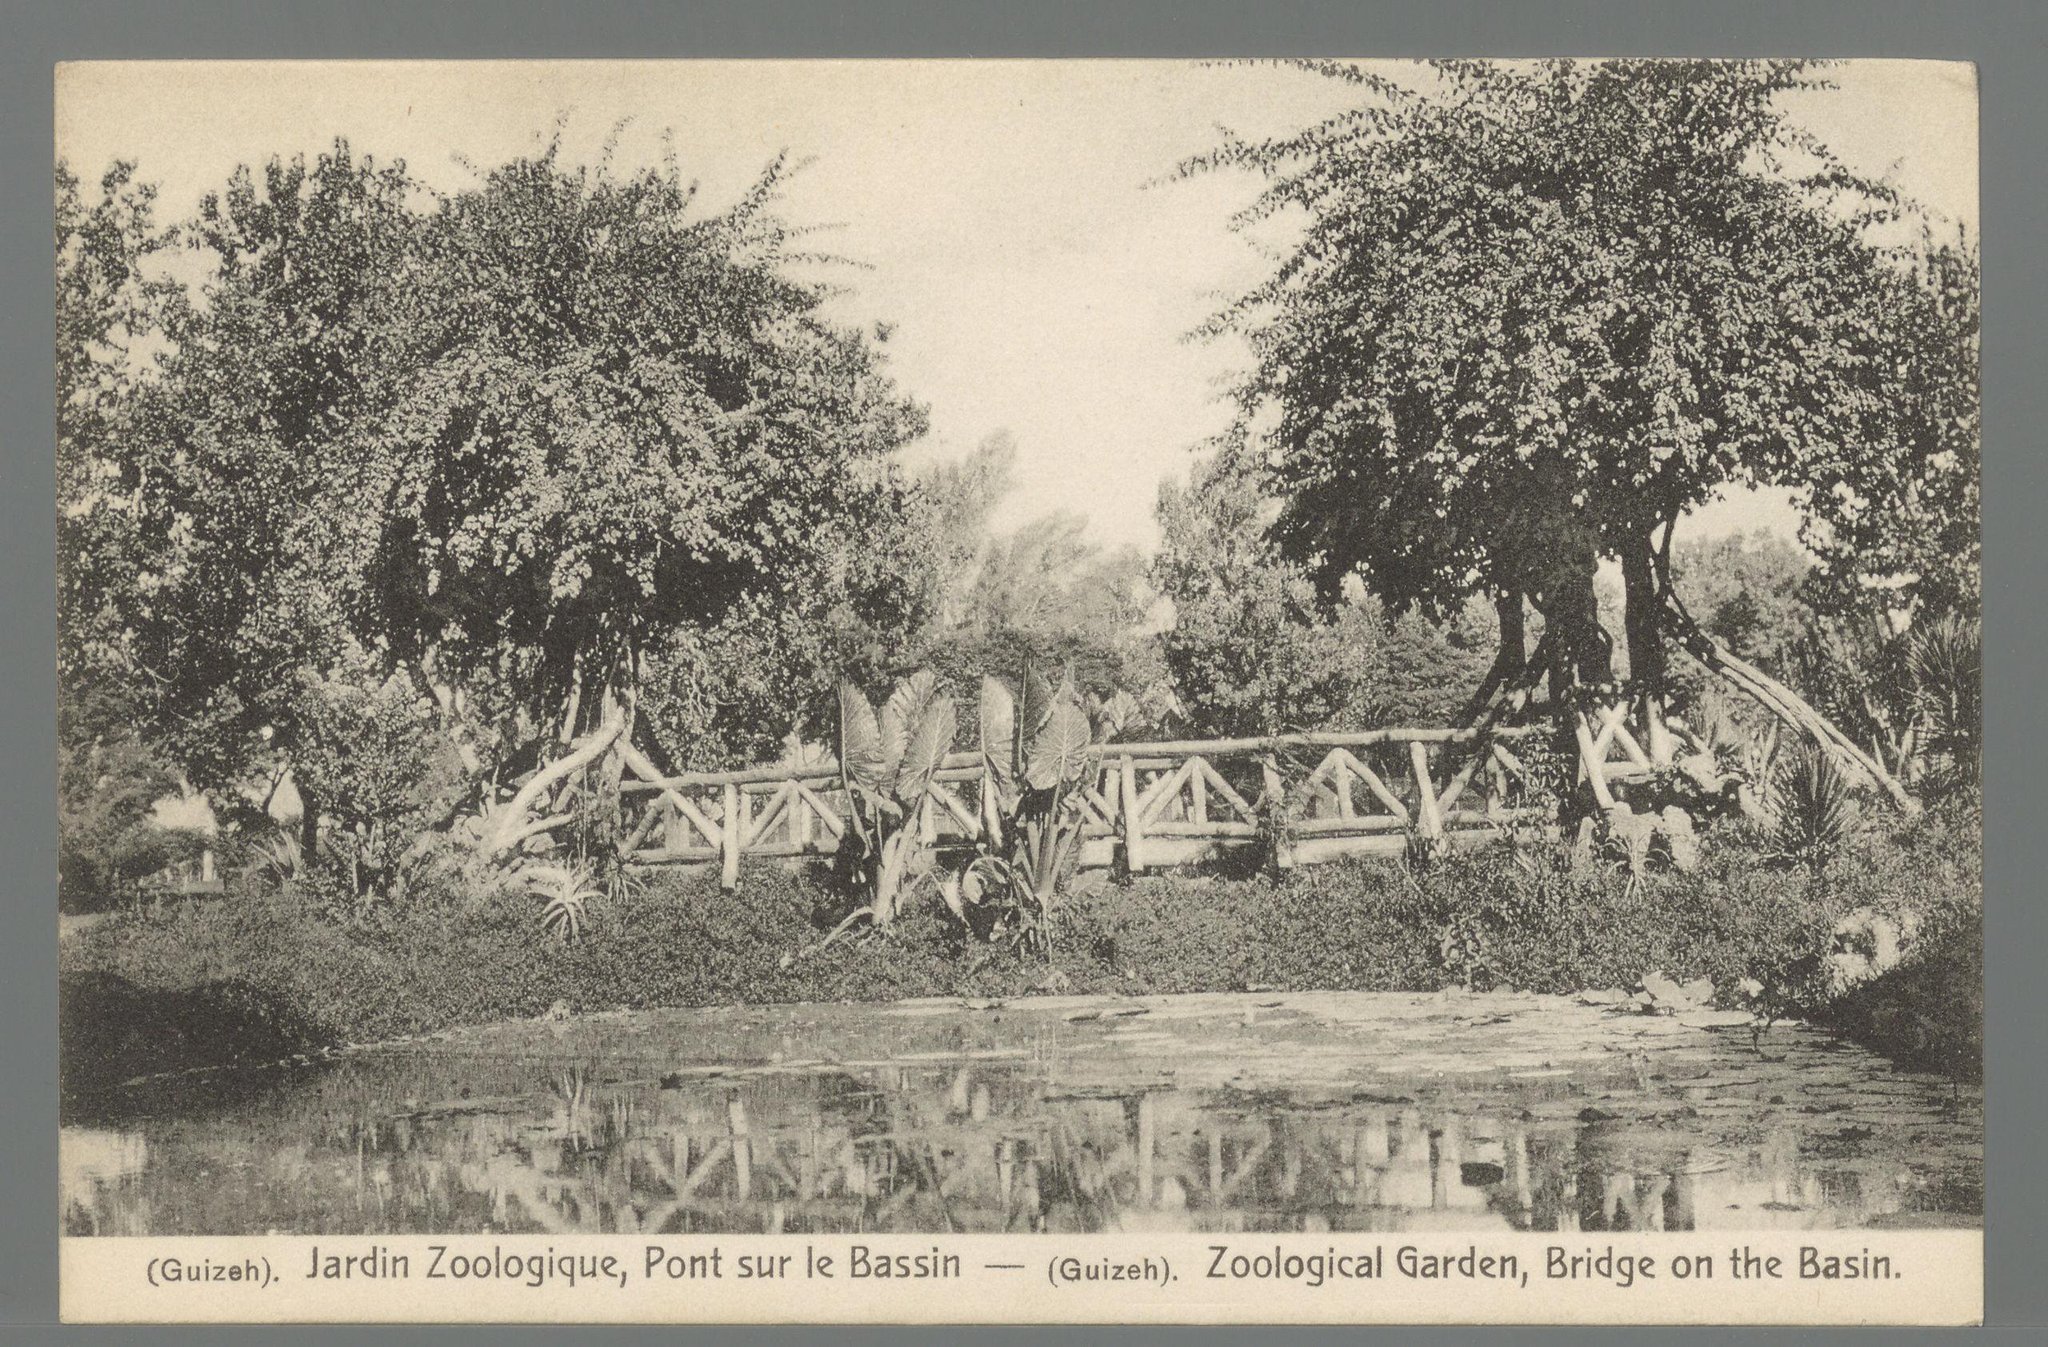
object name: photomechanical print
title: (Guizeh). Jadin Zoologique, pont sur le bassin / (Guizeh). Zoological Garden, bridge on the basin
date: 1907-1930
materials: cardboard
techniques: photograph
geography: gizeh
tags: zoological garden, zoo, seen as place where non-domestic animals are kept, pond, bridge